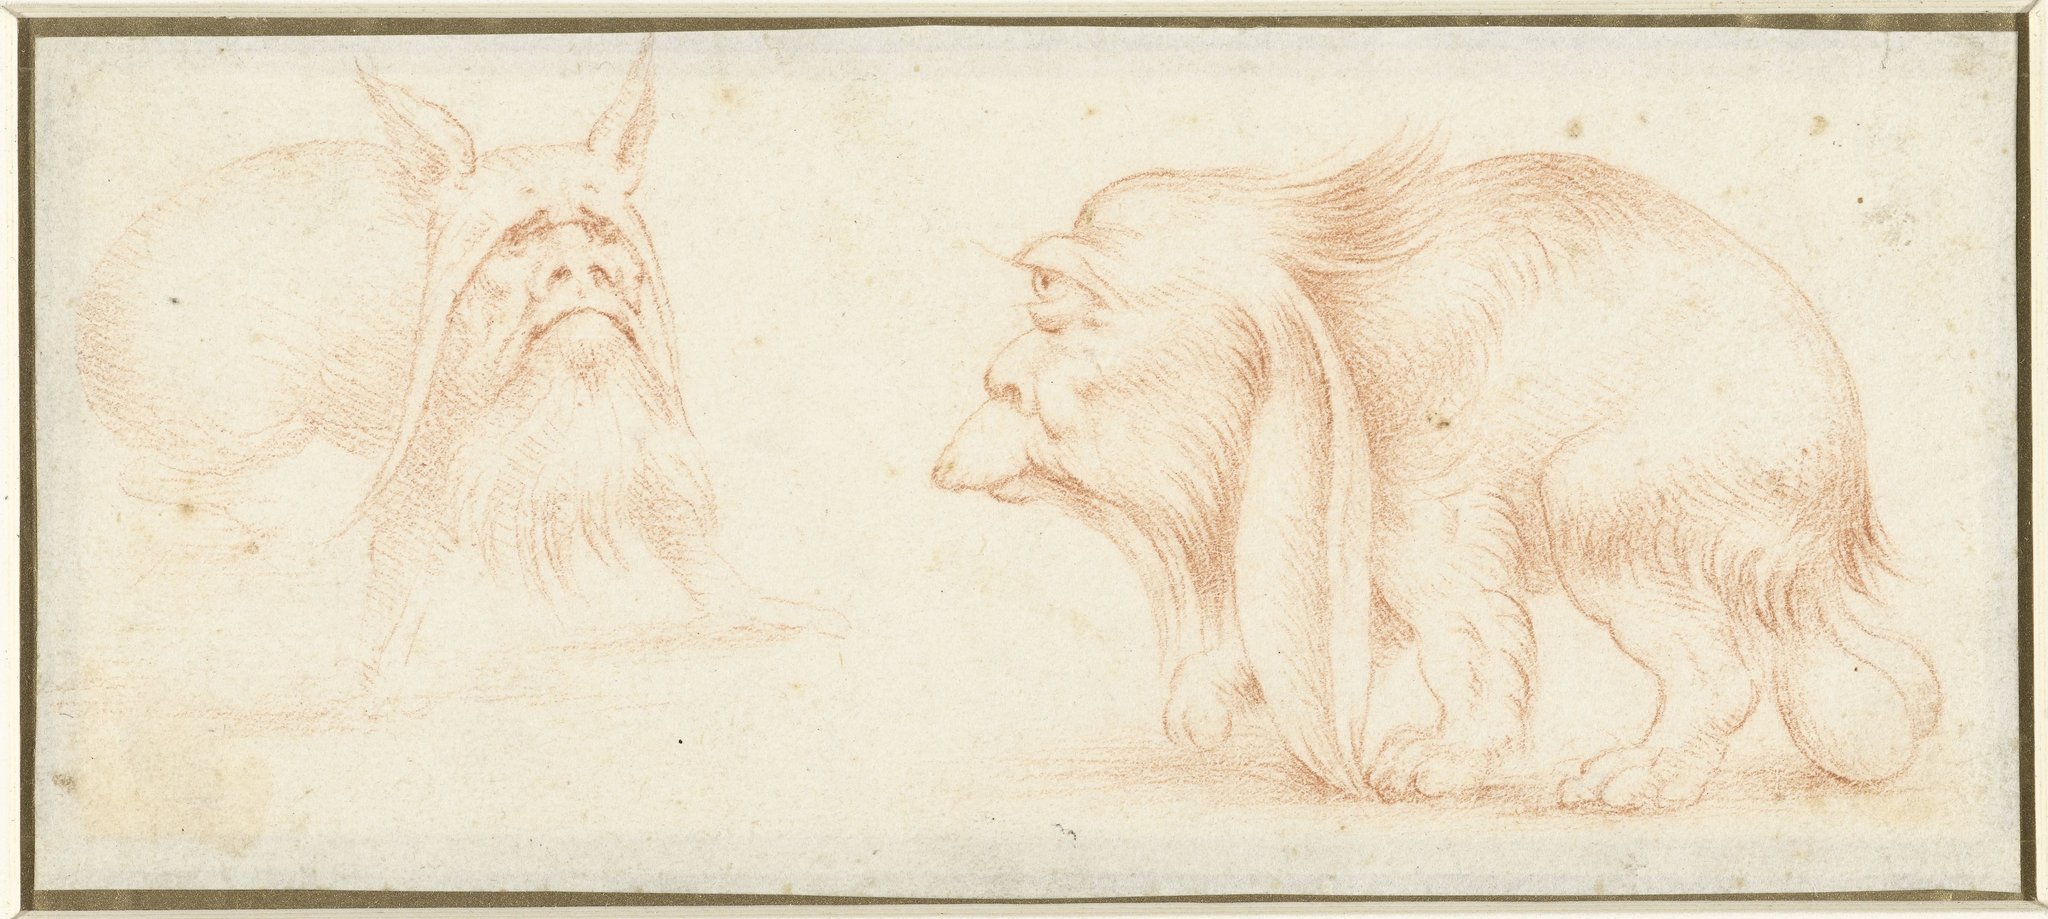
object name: drawing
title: Twee monsters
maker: francesco melzi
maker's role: draughtsman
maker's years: 1493-1570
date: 1503-1570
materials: chalk, paper